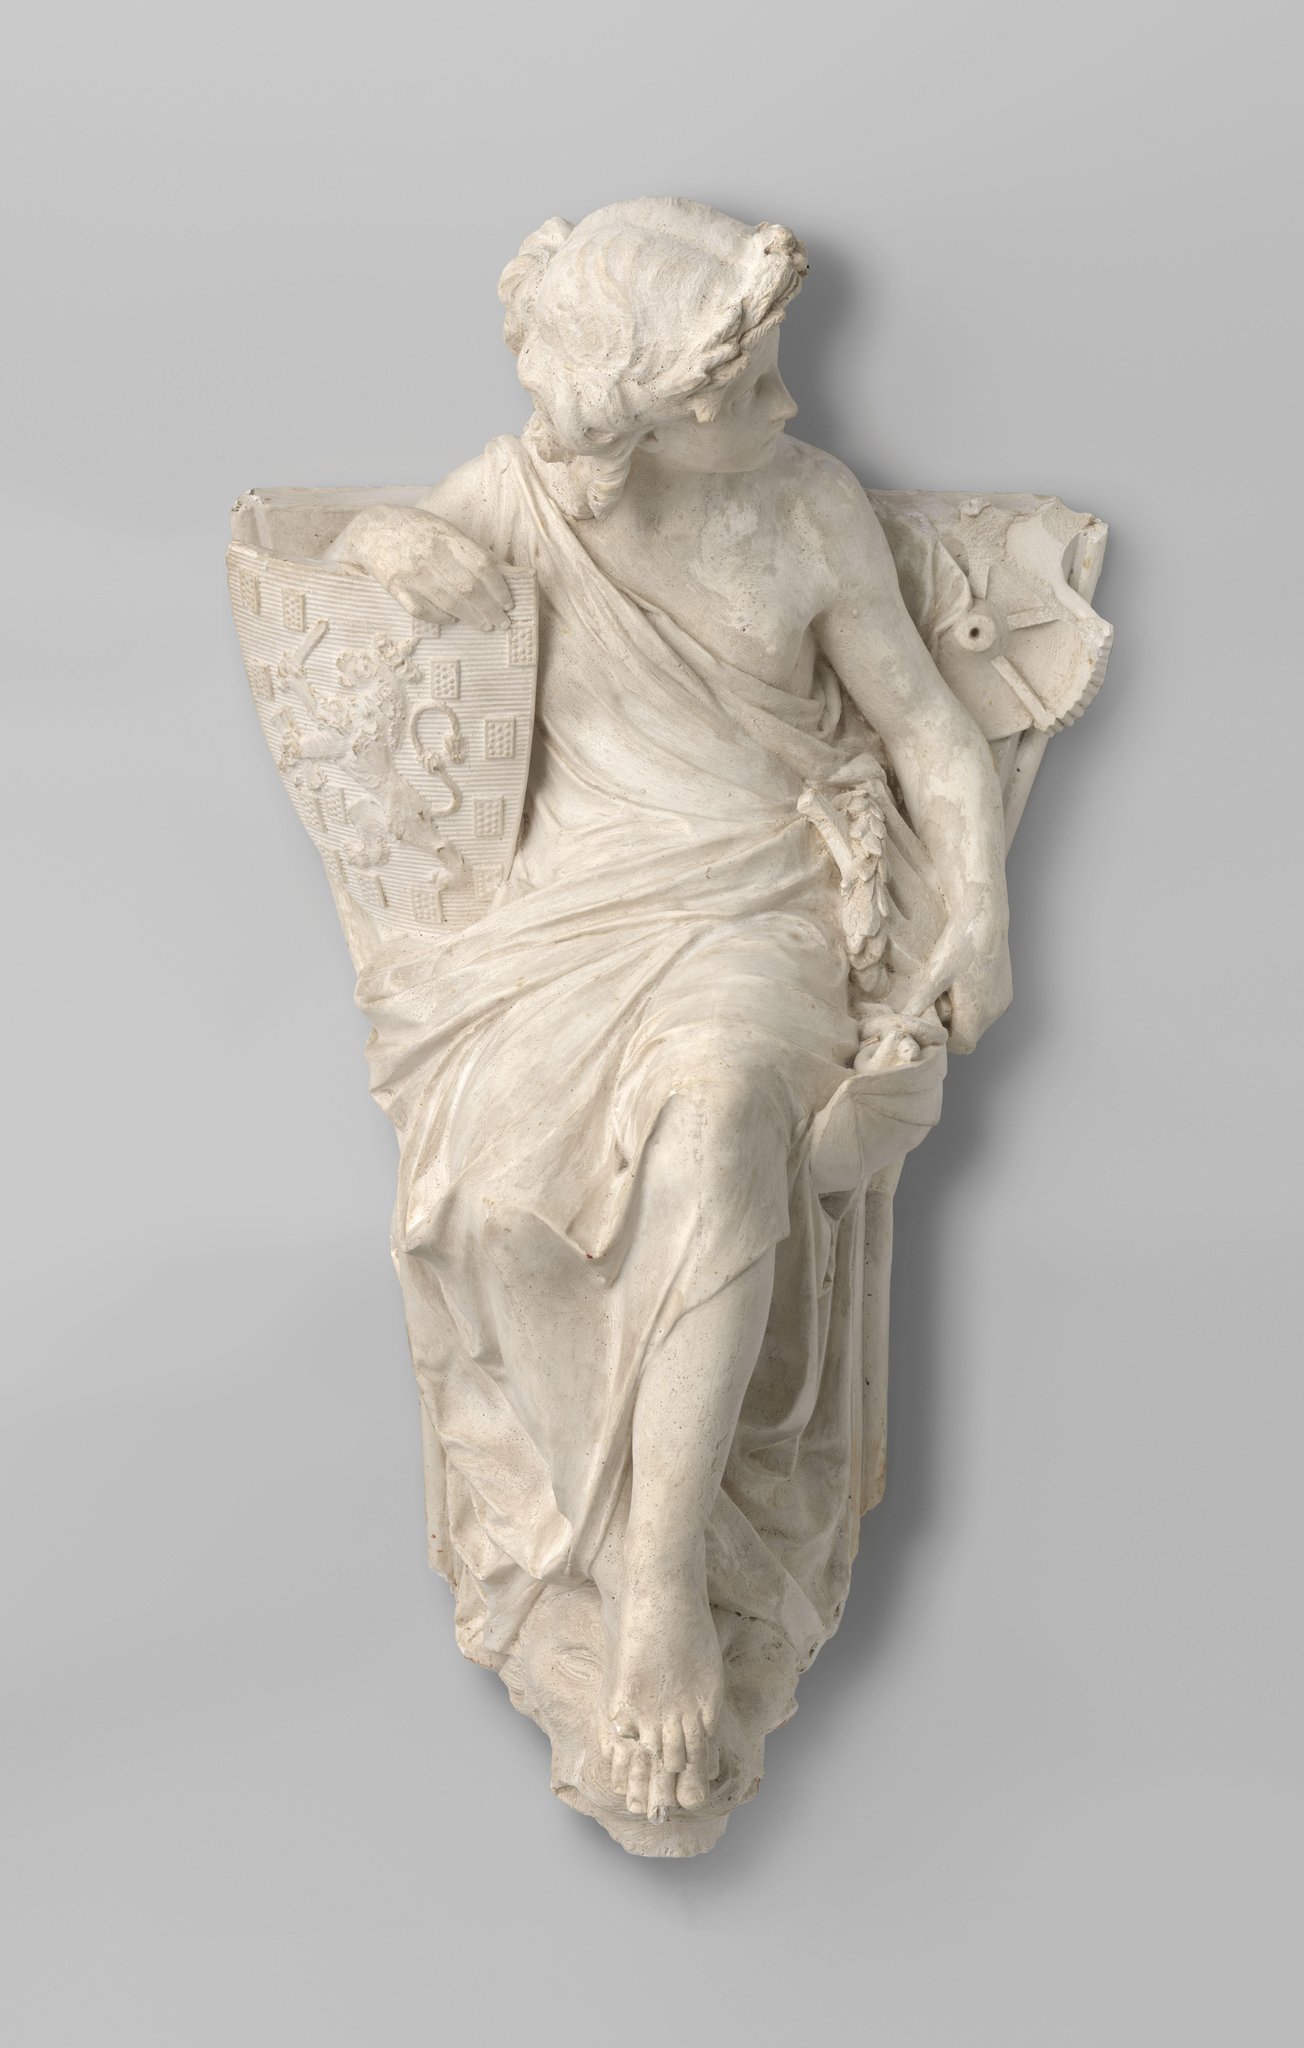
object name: sculpture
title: Fragment van de Oranjeboom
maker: frans stracké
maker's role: draughtsman, painter, sculptor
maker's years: 1820-1898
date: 1874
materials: gypsum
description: Achteroverleunende vrouwenfiguur. Haar voeten rusten op een leeuwenkop. In haar rechterhand houdt ze een schild. Onderdeel van een model in gips van een niet uitgevoerd milieu de table voor Willem III.